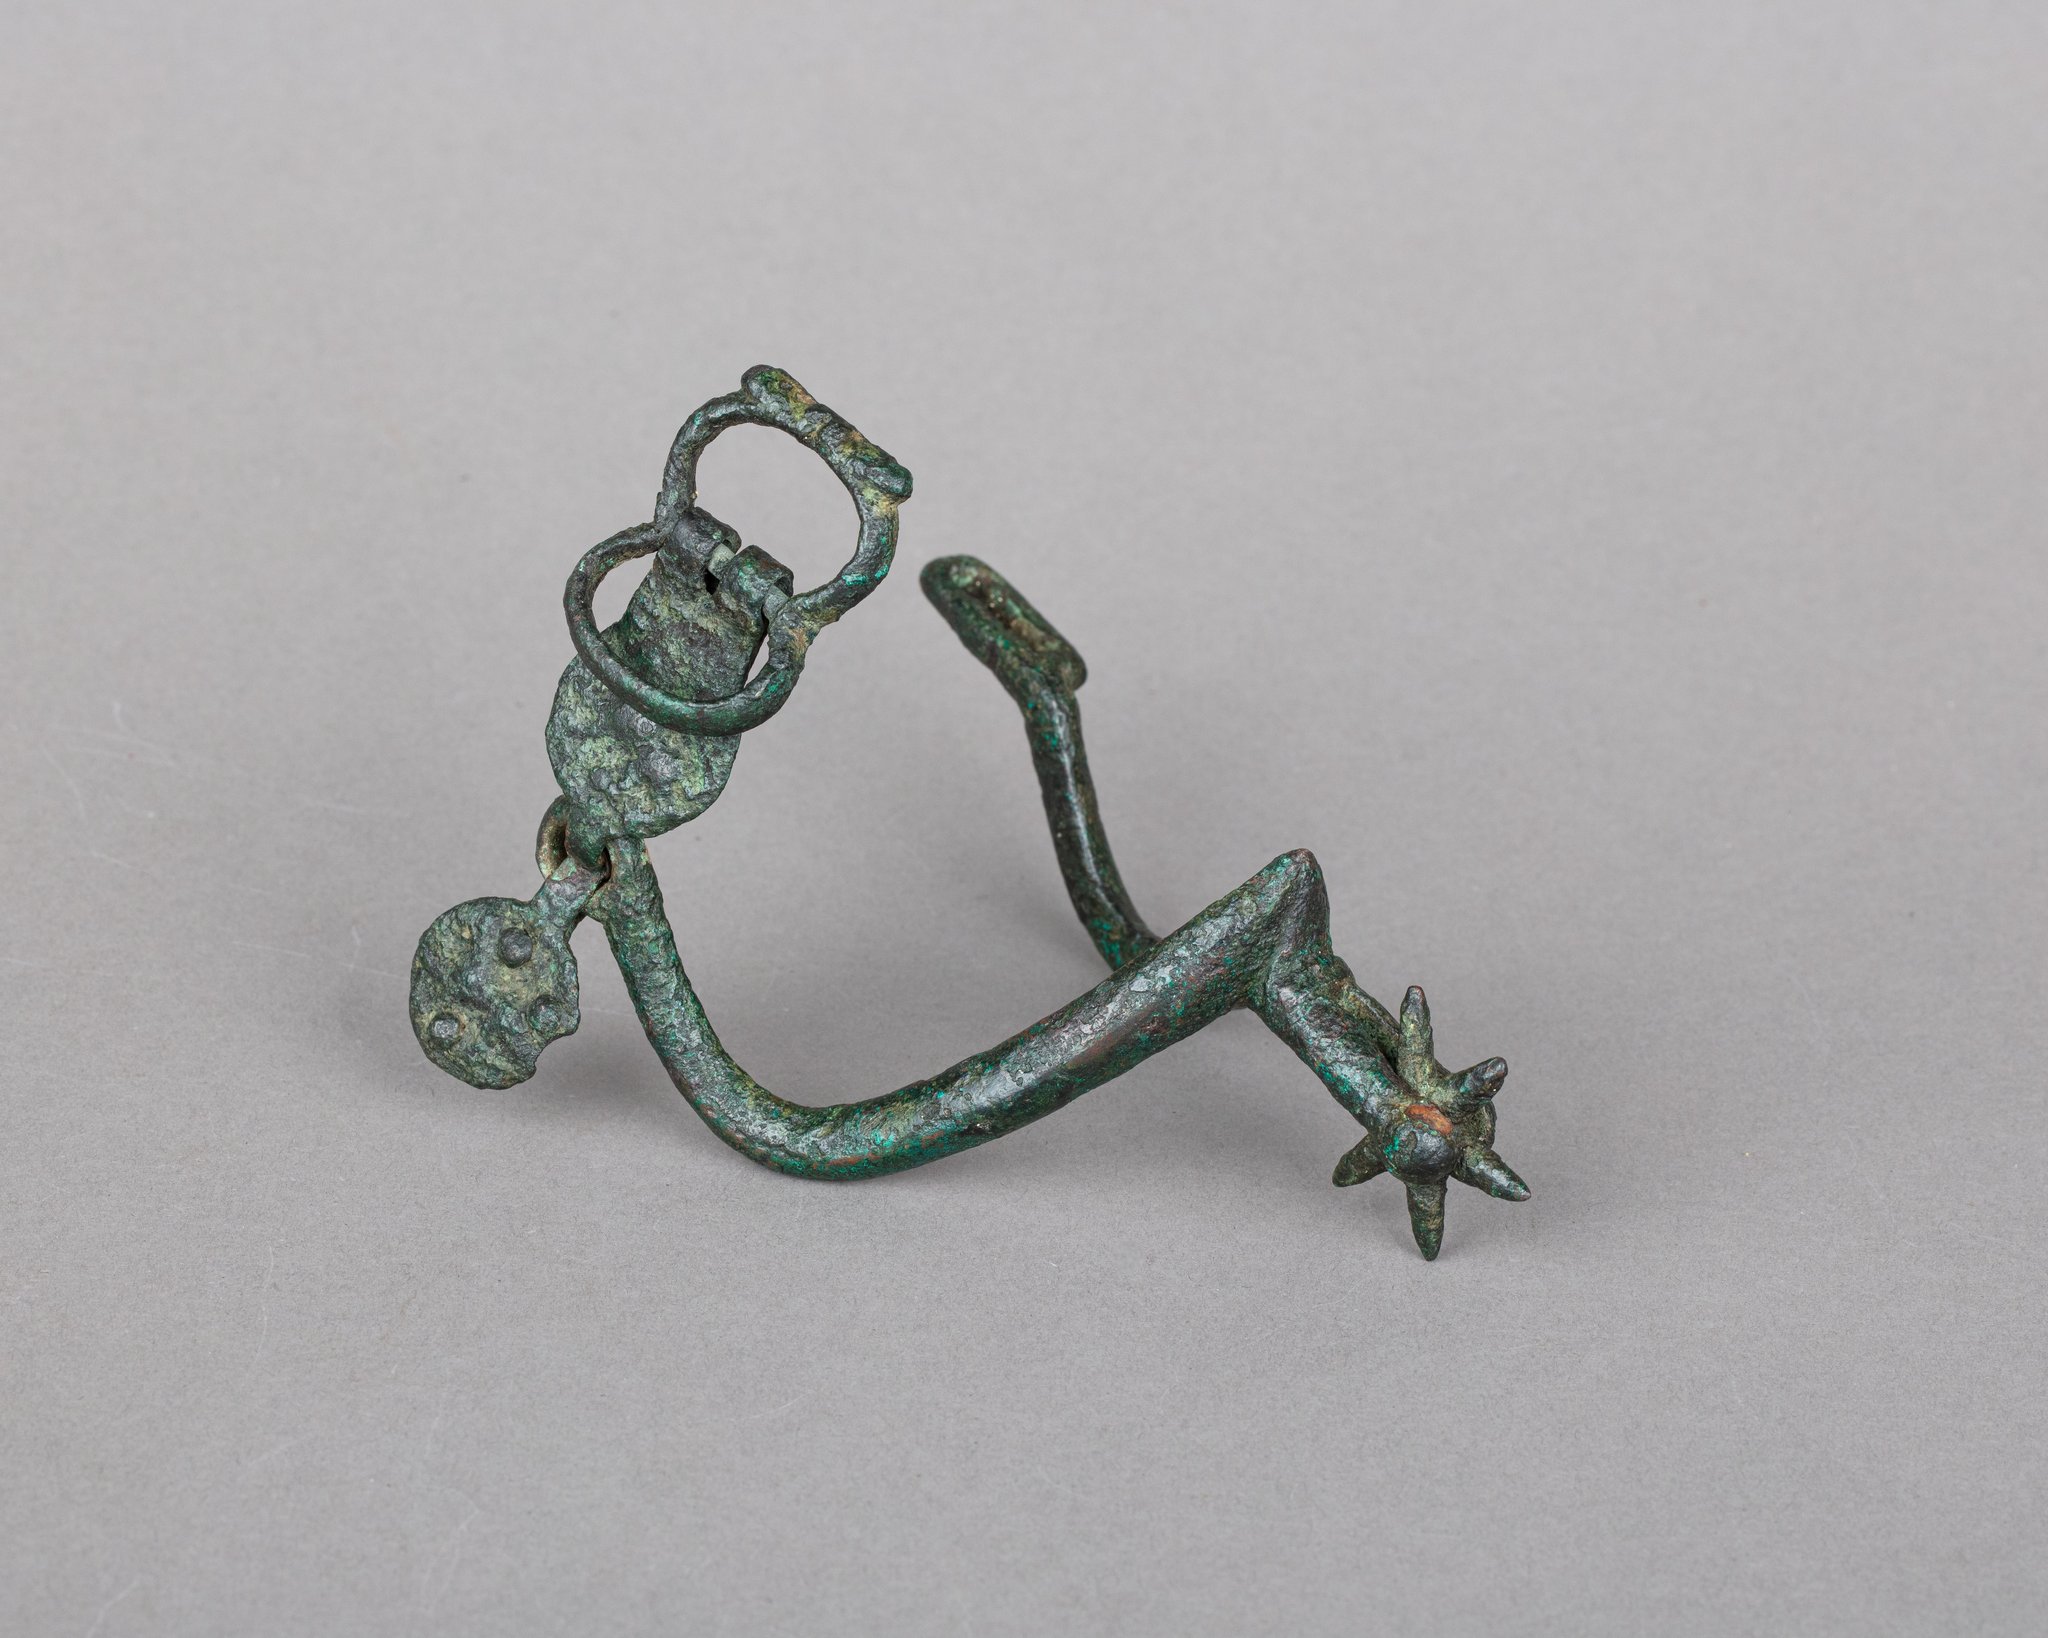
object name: spur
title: Rowel Spur (Left)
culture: italian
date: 1301-1350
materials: copper alloy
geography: france